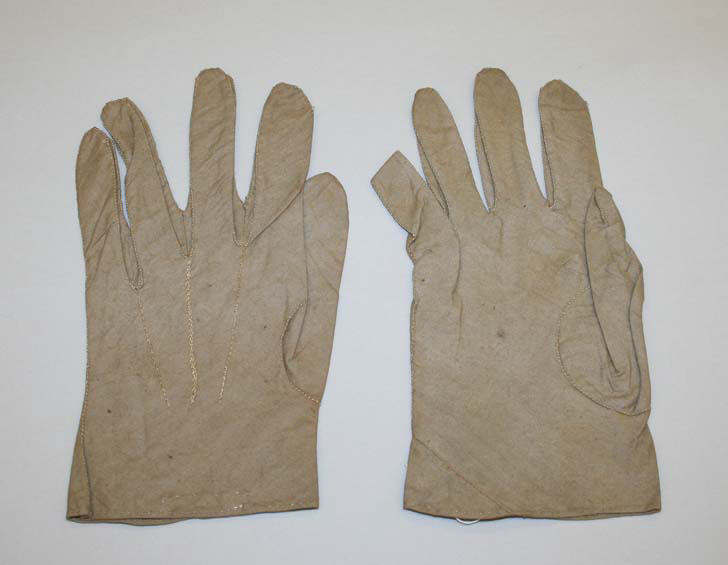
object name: glove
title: Gloves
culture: american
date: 1801-1833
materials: cotton